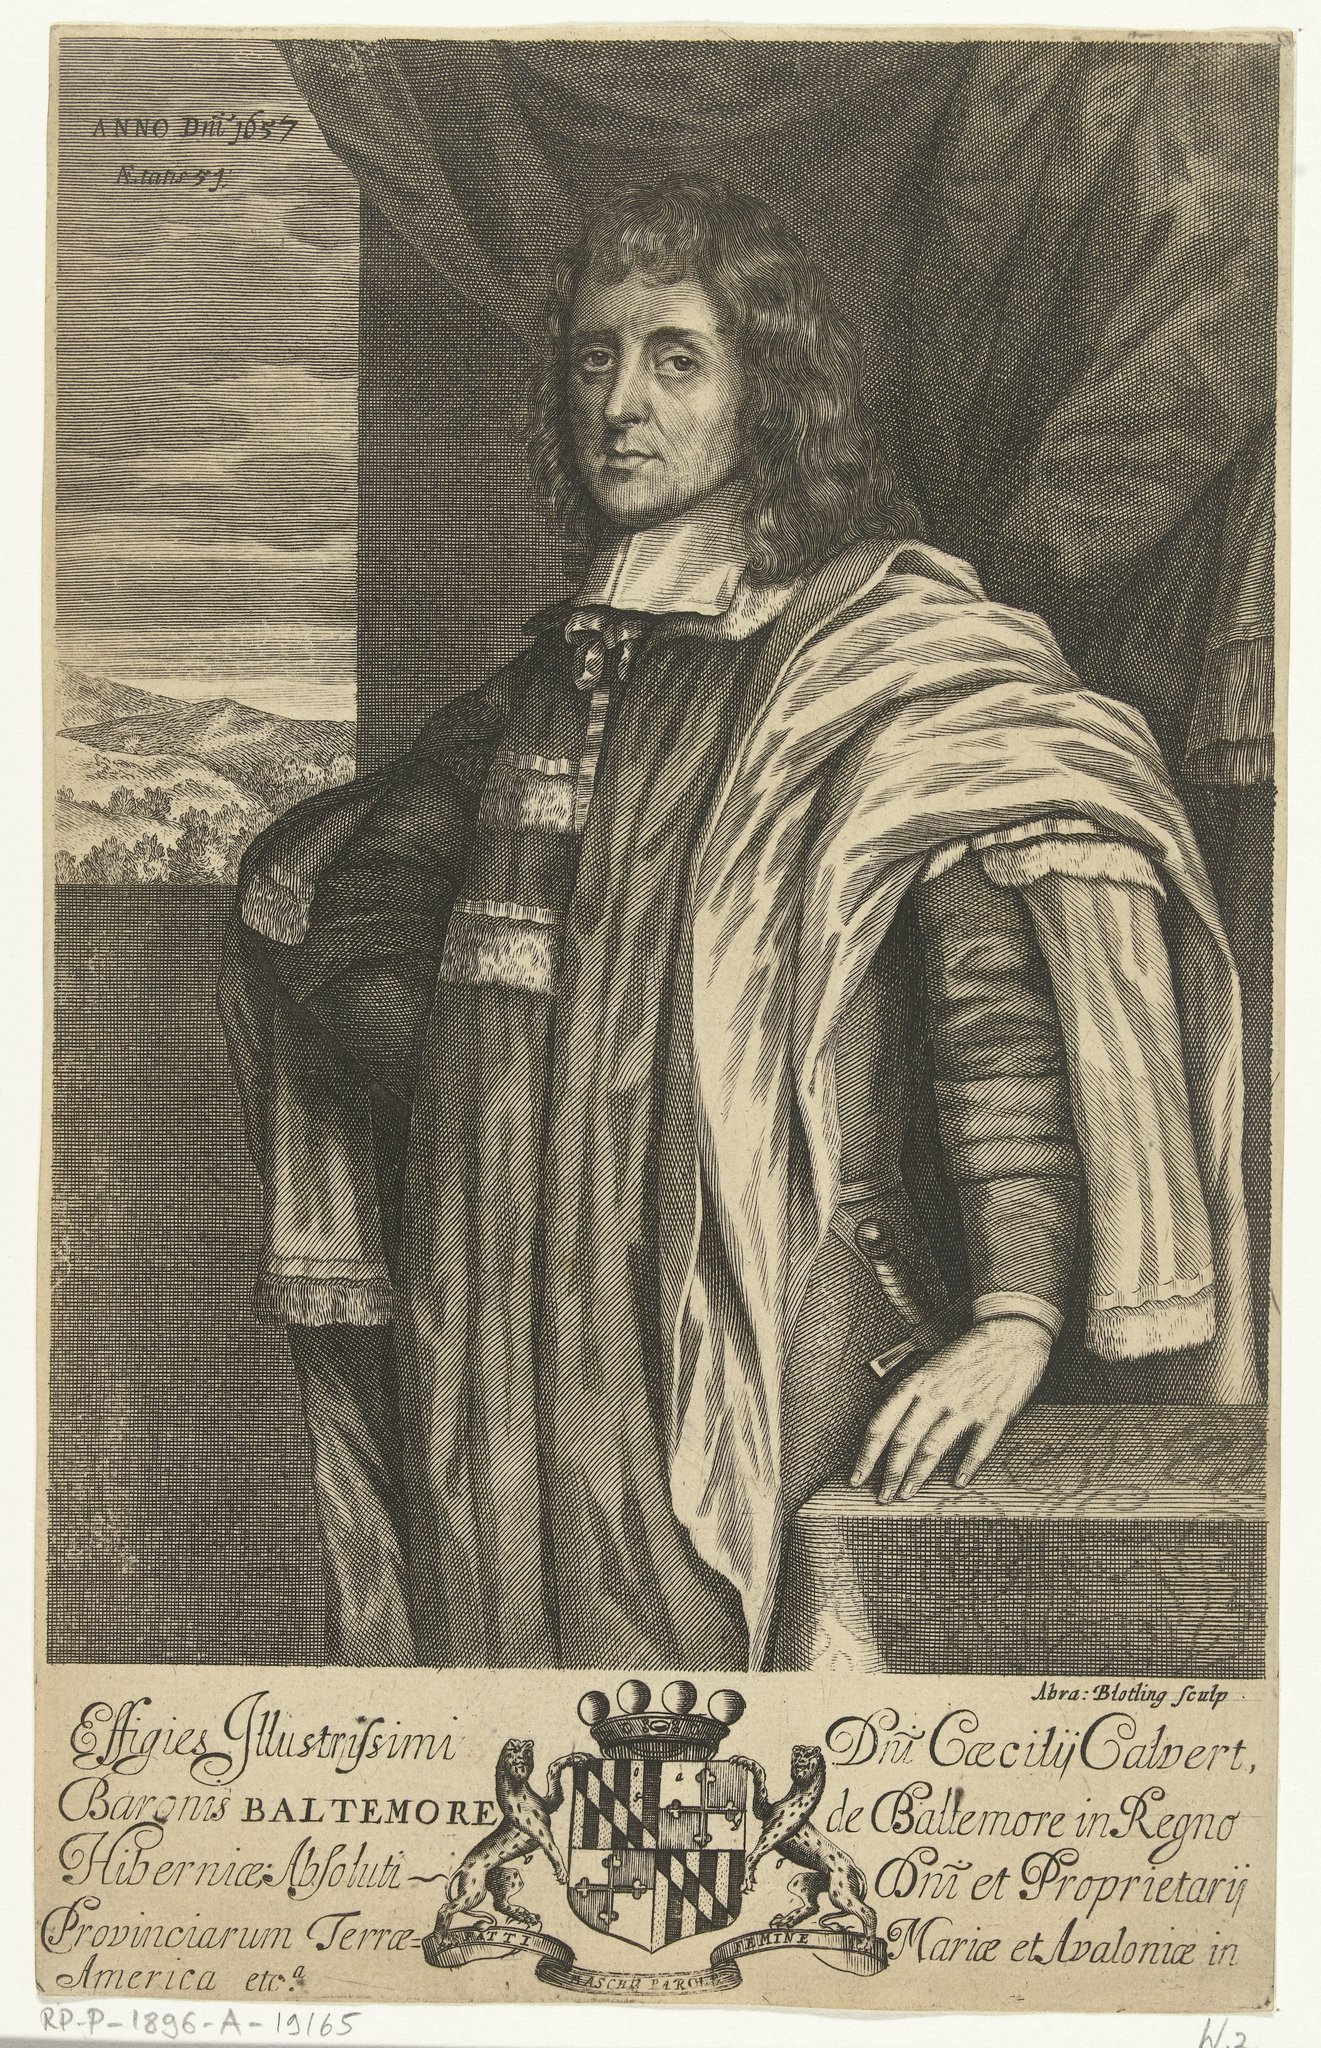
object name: print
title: Effigies Illustrissimi Dni Caecilii Calvert (...)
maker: abraham bloteling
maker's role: draughtsman, print maker, publisher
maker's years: 1640-1690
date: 1657-1690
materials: paper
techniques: engraving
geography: london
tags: cecilius calvert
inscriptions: collector's mark: Lugt 2228